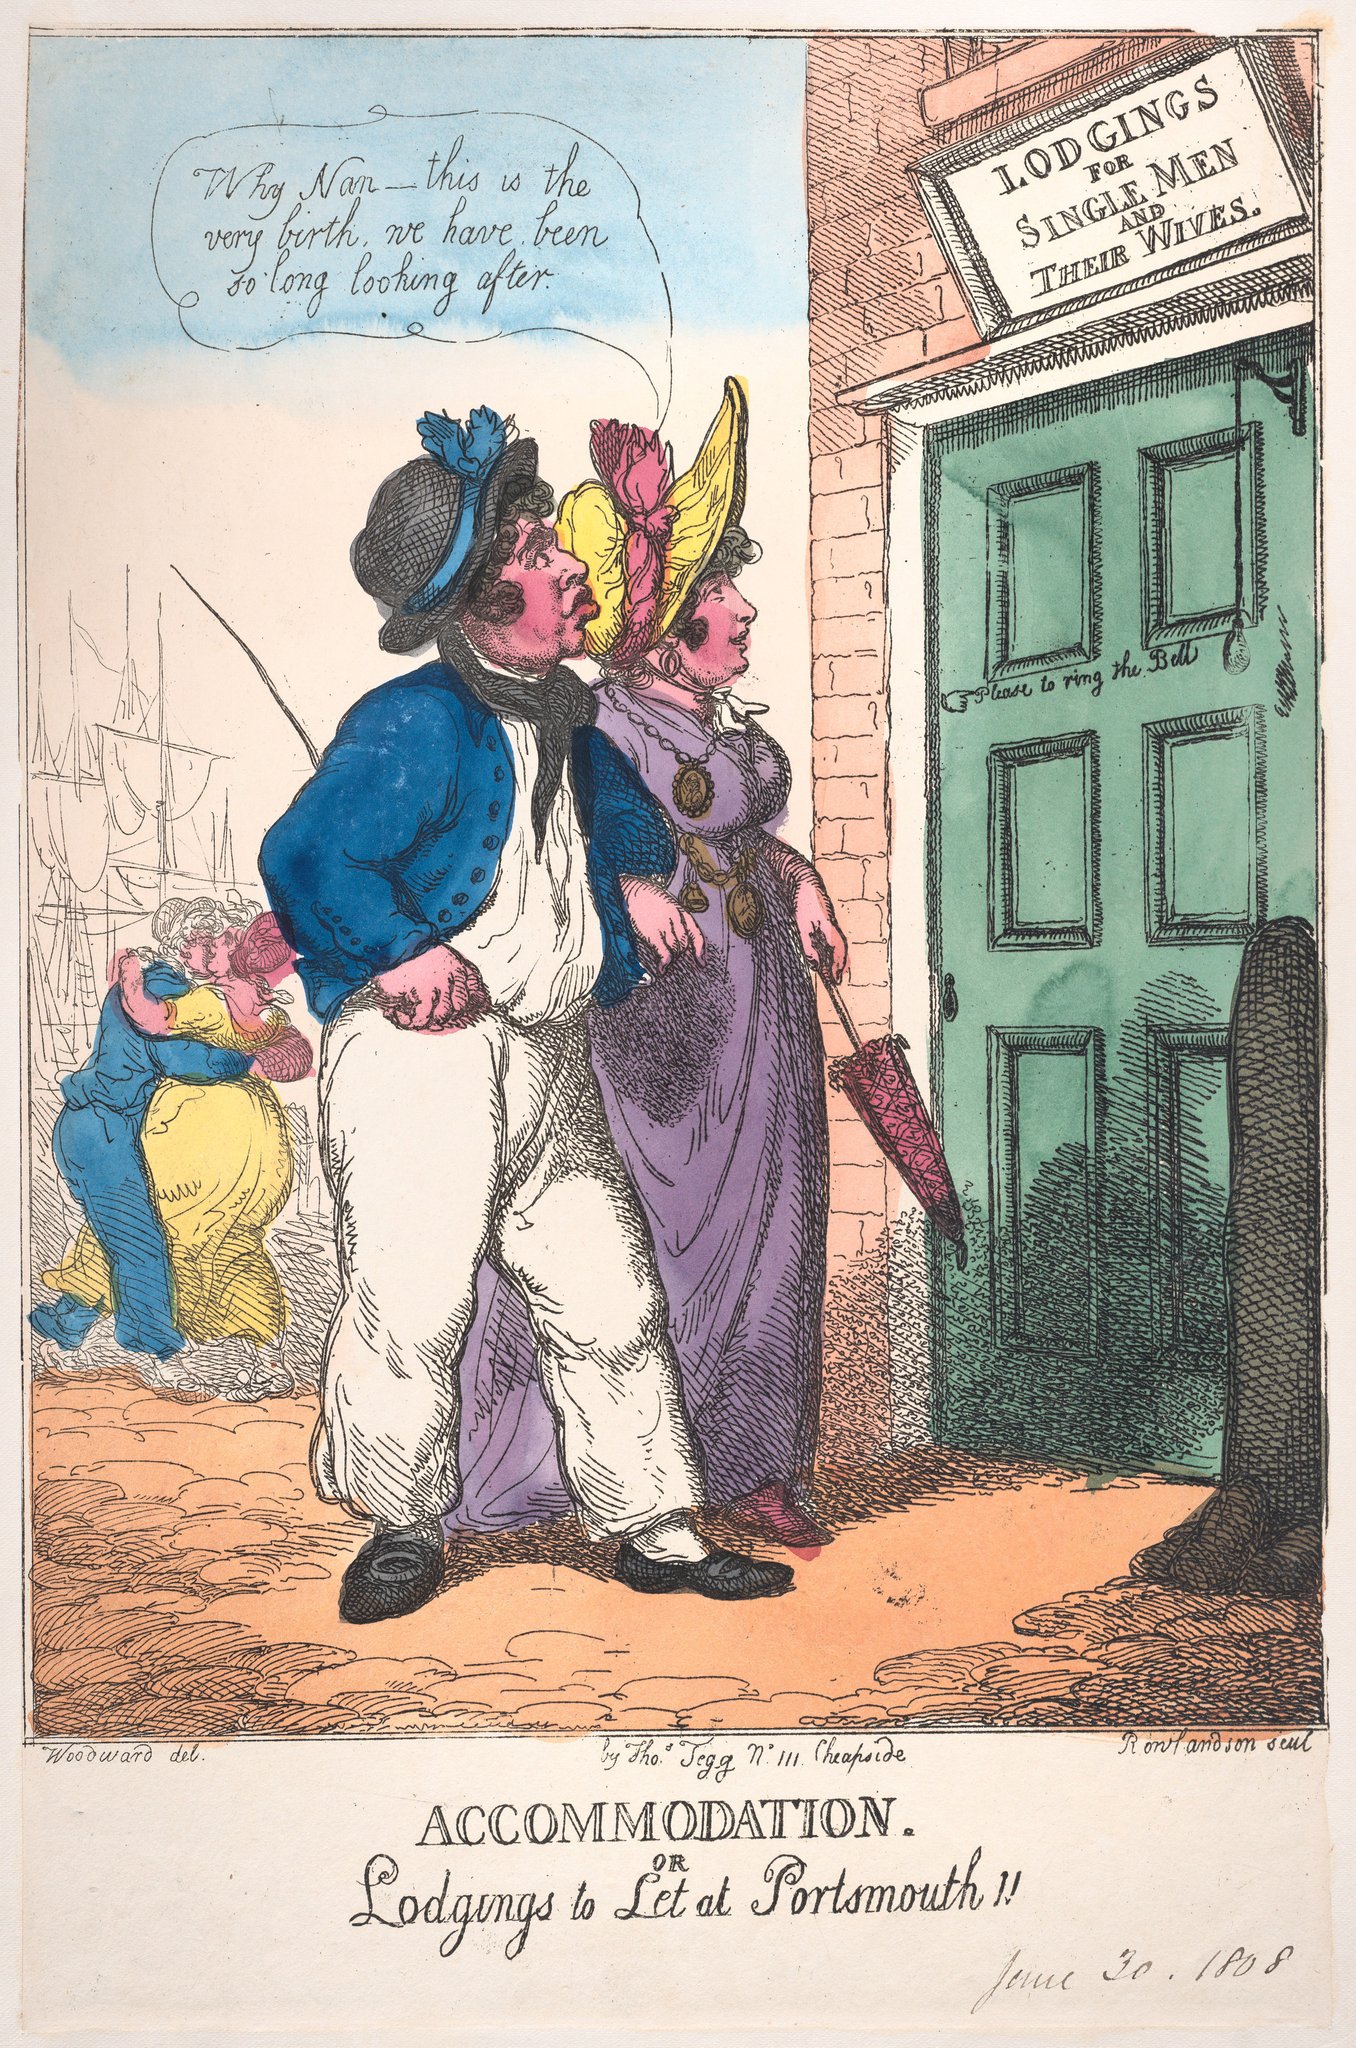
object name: print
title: Accommodation, or Lodgings to Let at Portsmouth!!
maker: thomas rowlandson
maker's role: artist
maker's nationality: british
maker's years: 1757-1827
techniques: etching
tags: satire,couples,men,women